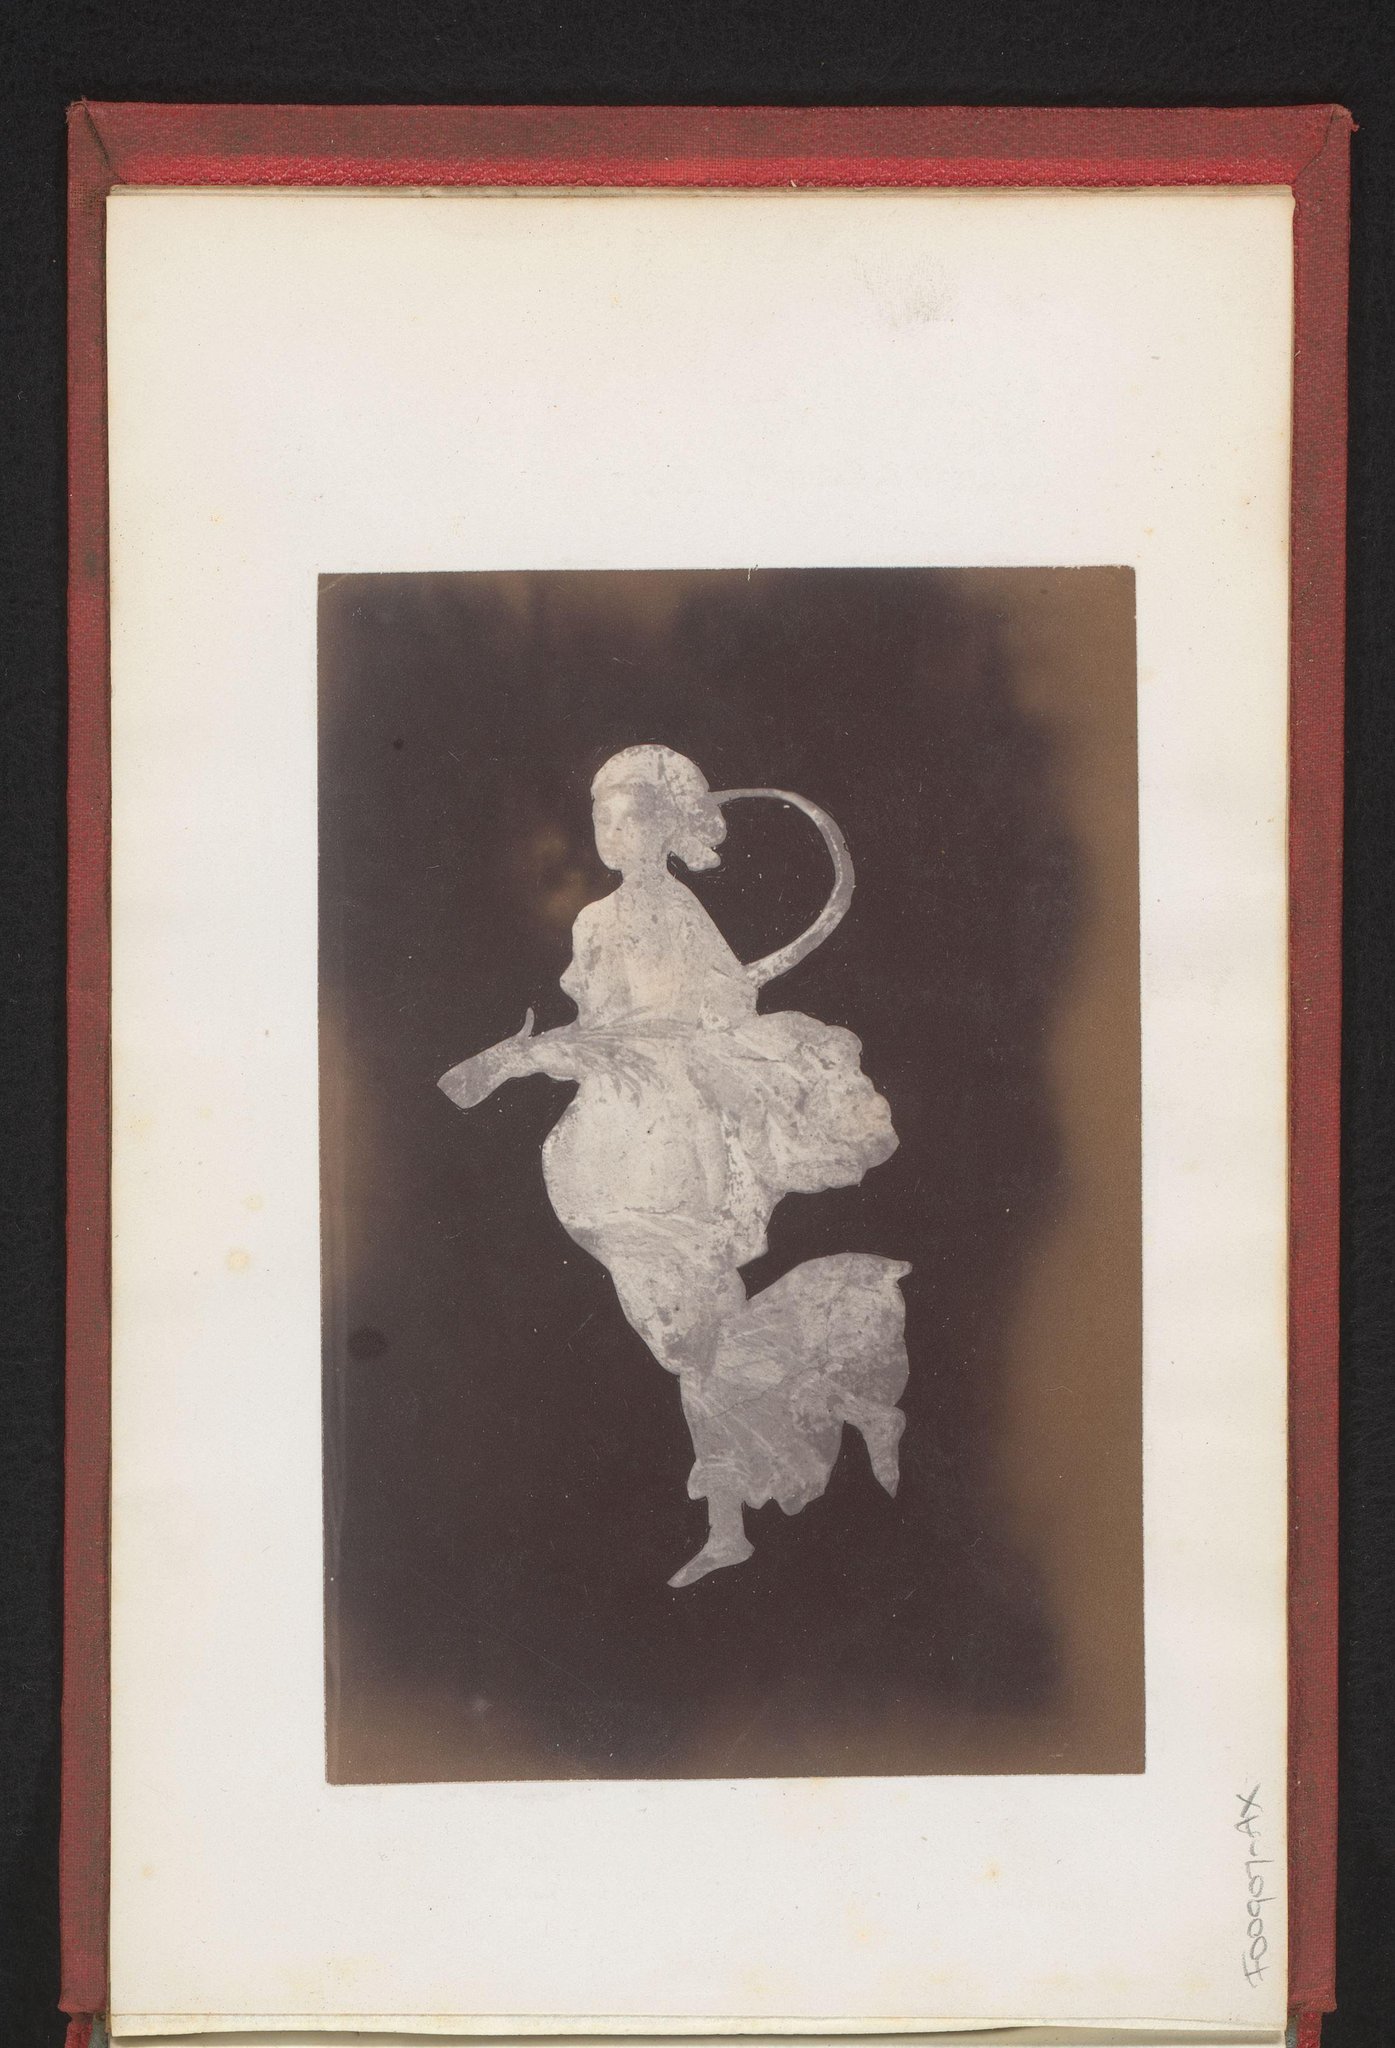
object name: reproduction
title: Fotoreproductie van een fresco te Pompeï van halfnaakte vrouw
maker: Anonymous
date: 1860-1900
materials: photographic support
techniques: albumen print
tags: (almost) naked ~ ascetic life, painting, drawing and the graphic arts, pompeii